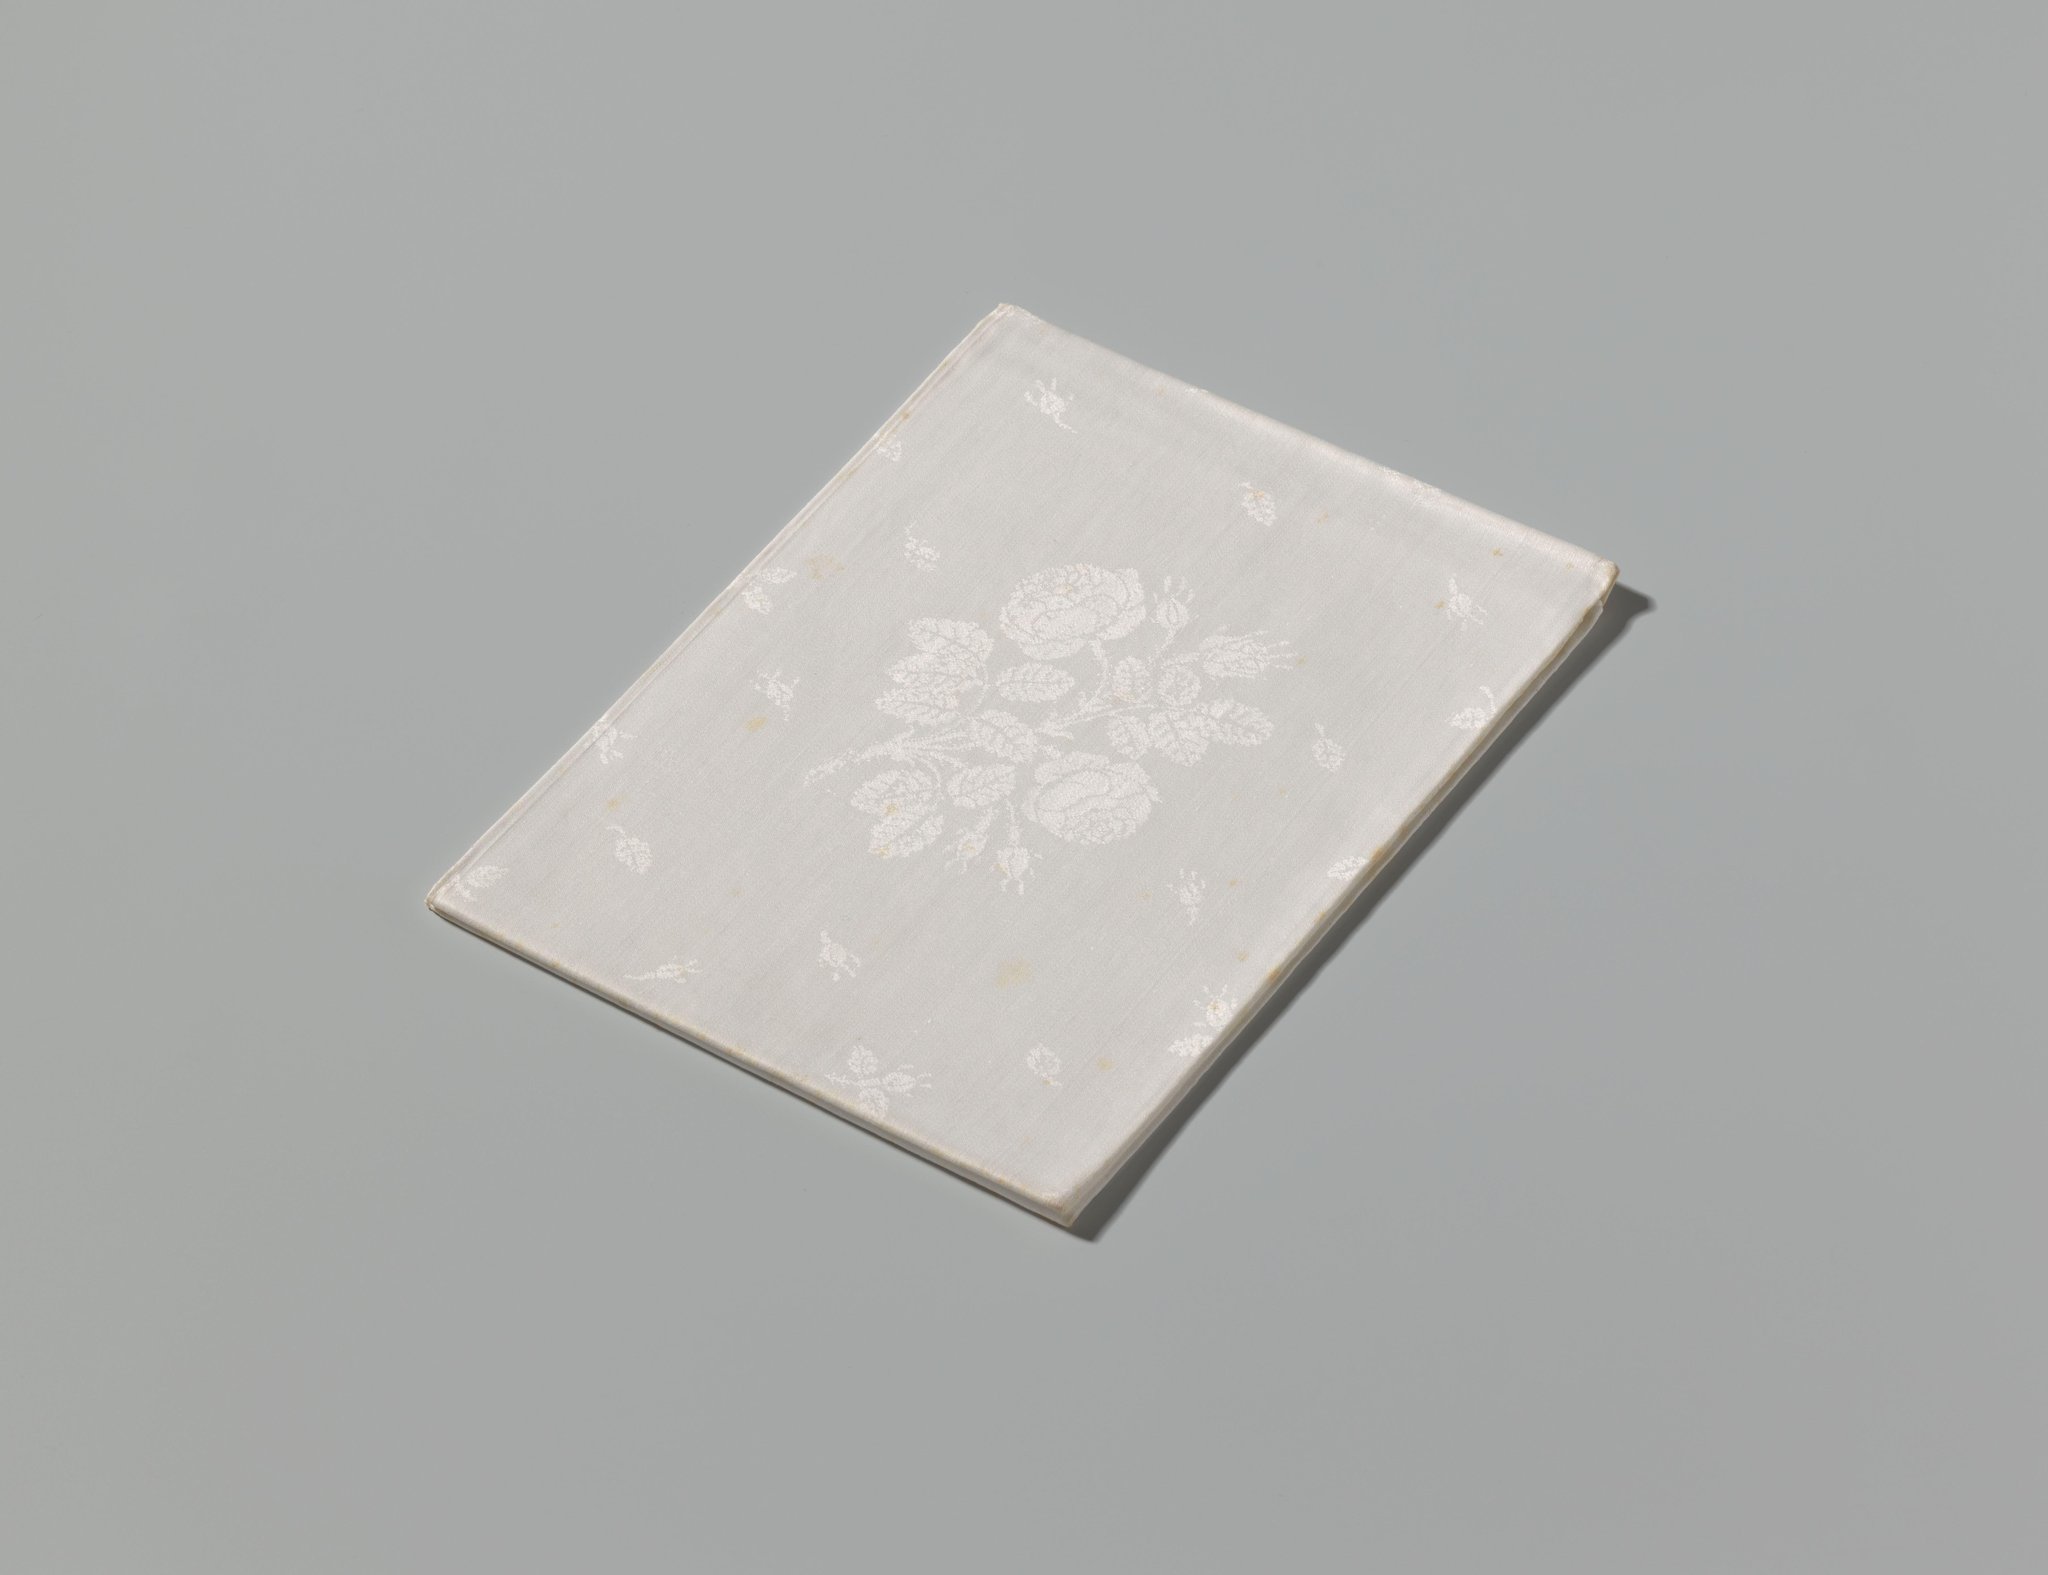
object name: napkin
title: Servet van linnendamast met bloemen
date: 1800-1900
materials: linen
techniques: damask, weave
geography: north brabant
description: Servet van linnendamast. Het veld heeft vier rozentakken en gestrooide bladeren en knoppen. Langs de rand van het veld loopt een rand met rozentakken die in de hoek zijn samengebonden met een strik. Langs de rand loopt een band met druiventrossen en -bladeren. Het servet is in rood gemerkt met een kruissteek: G (C?) 40.